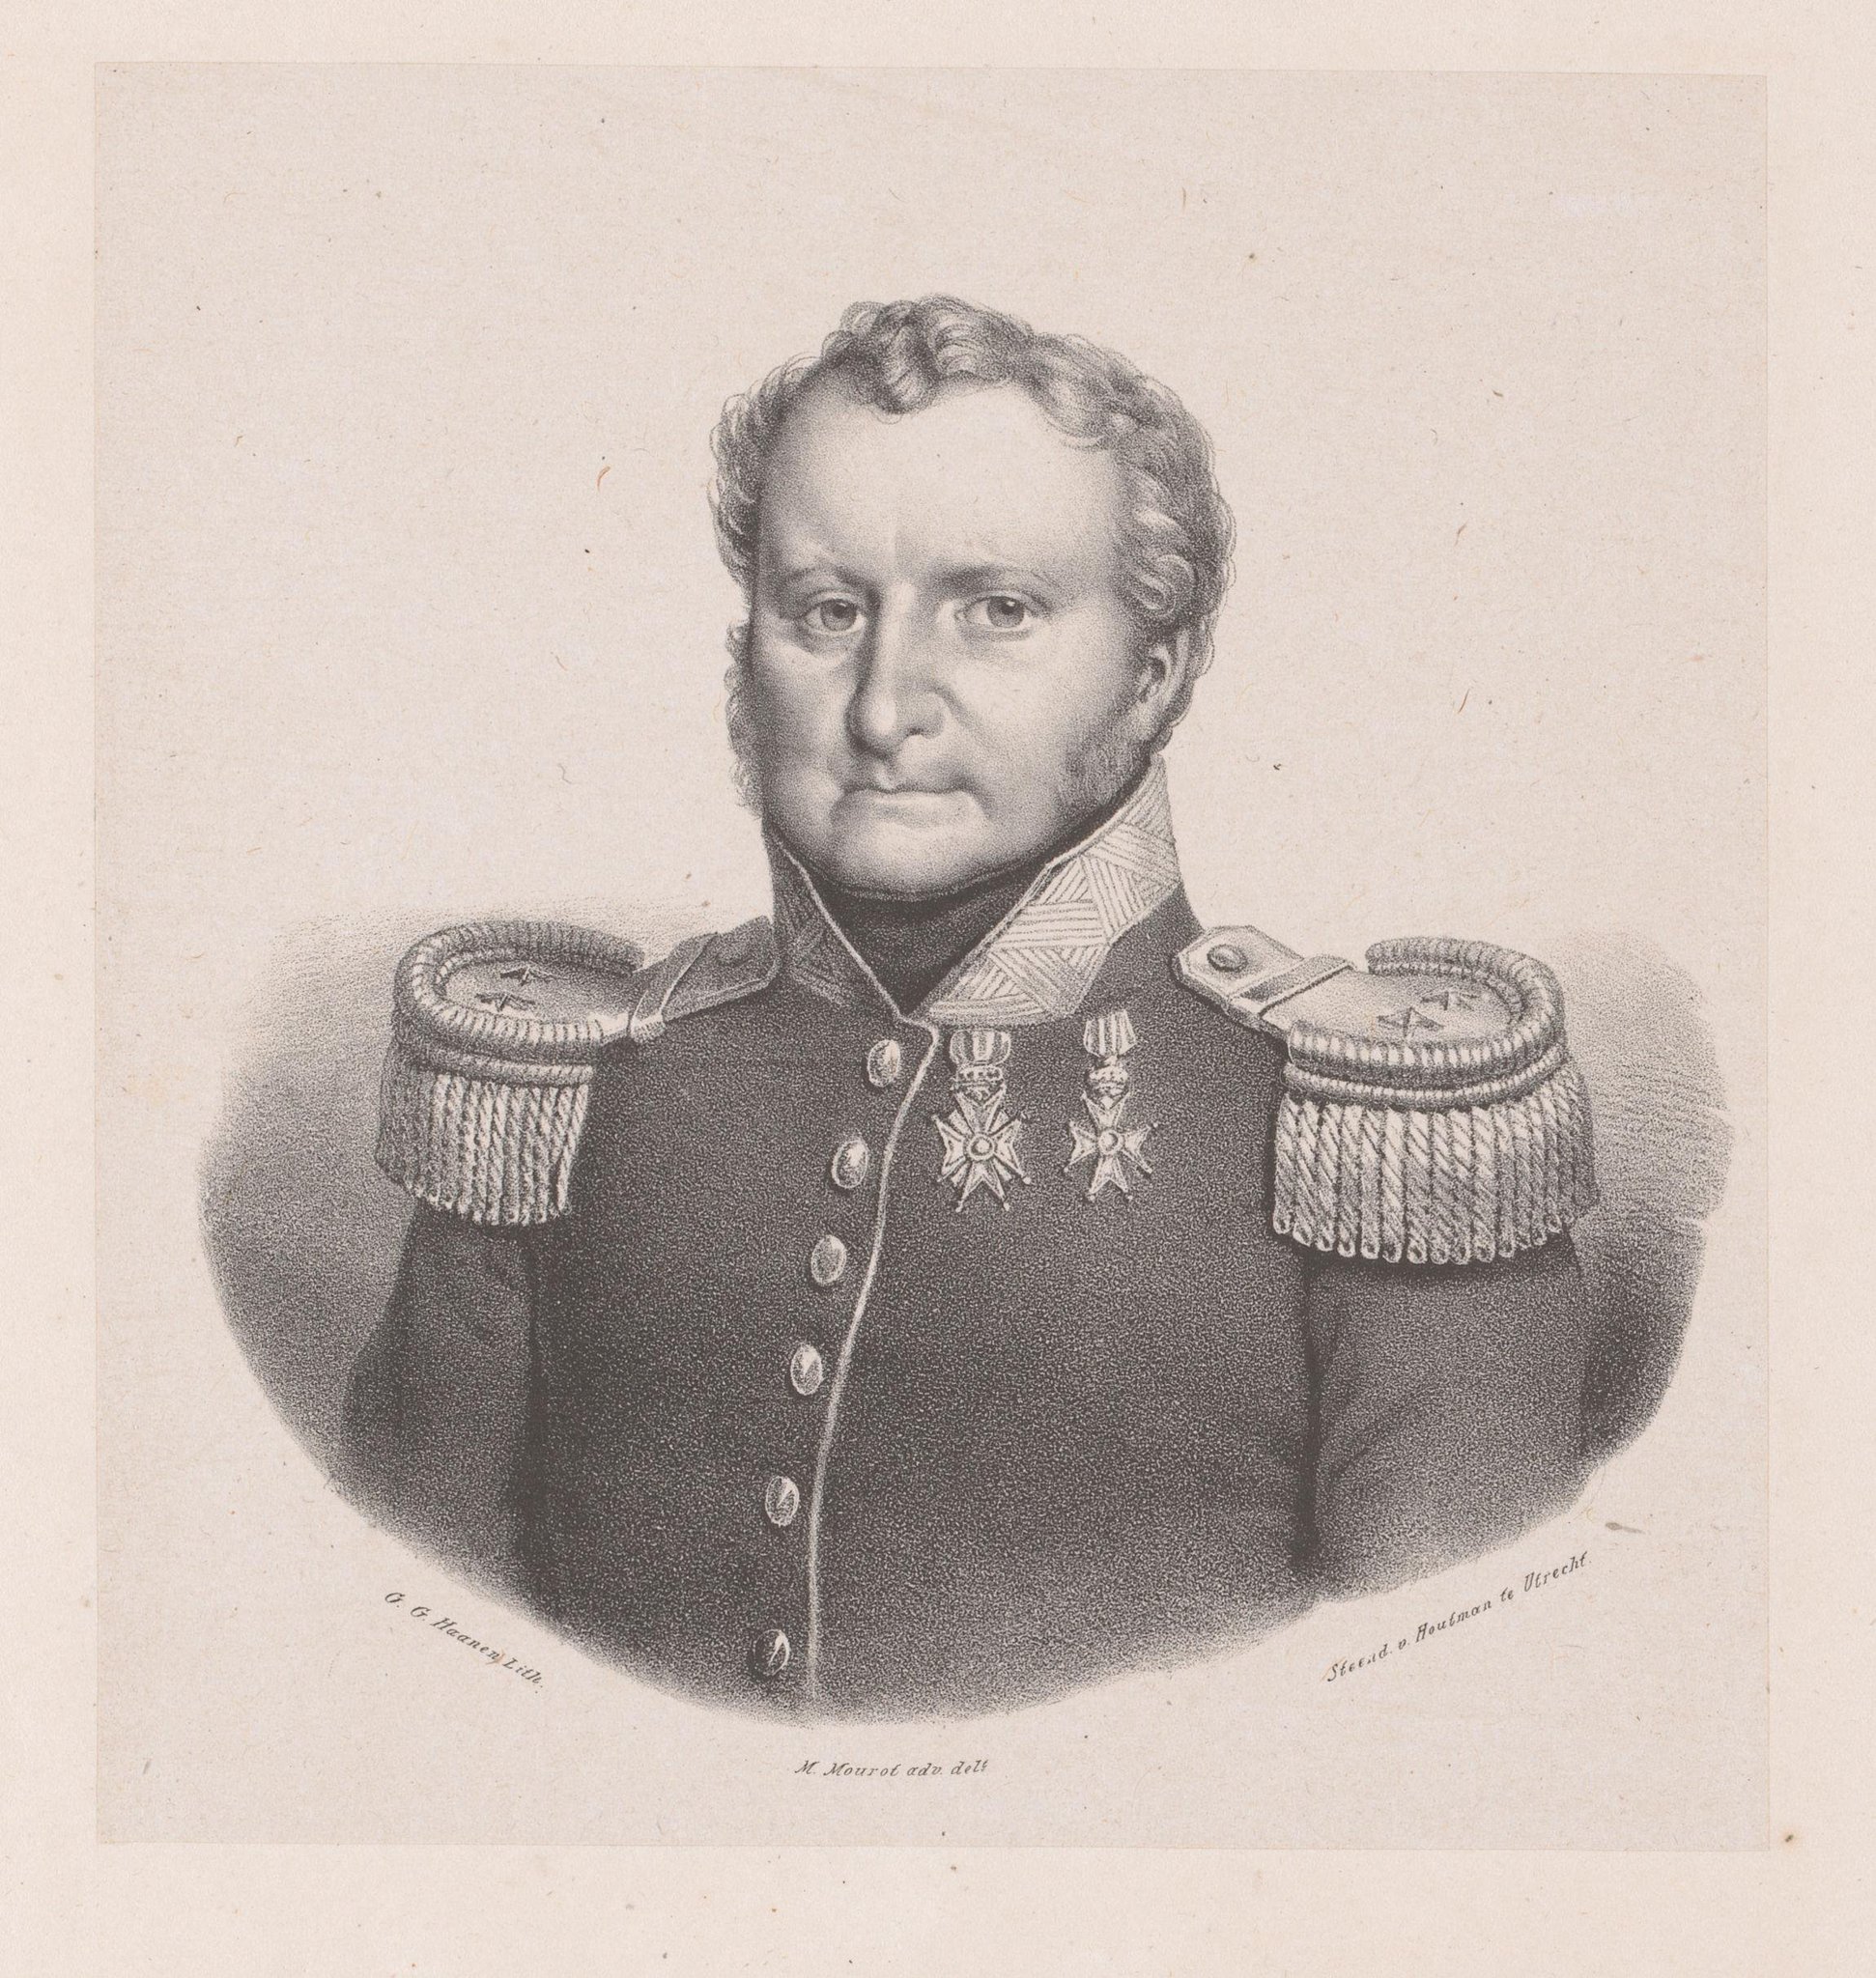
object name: print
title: Portret van Frederik Benjamin Alexander Philip van der Capellen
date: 1817-1879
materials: paper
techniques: lithograph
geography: netherlands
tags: knighthood order, historical persons (+ (full) bust portrait)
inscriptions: collector's mark: Lugt 2228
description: De geportretteerde draagt een militair uniform en twee ridderorden.